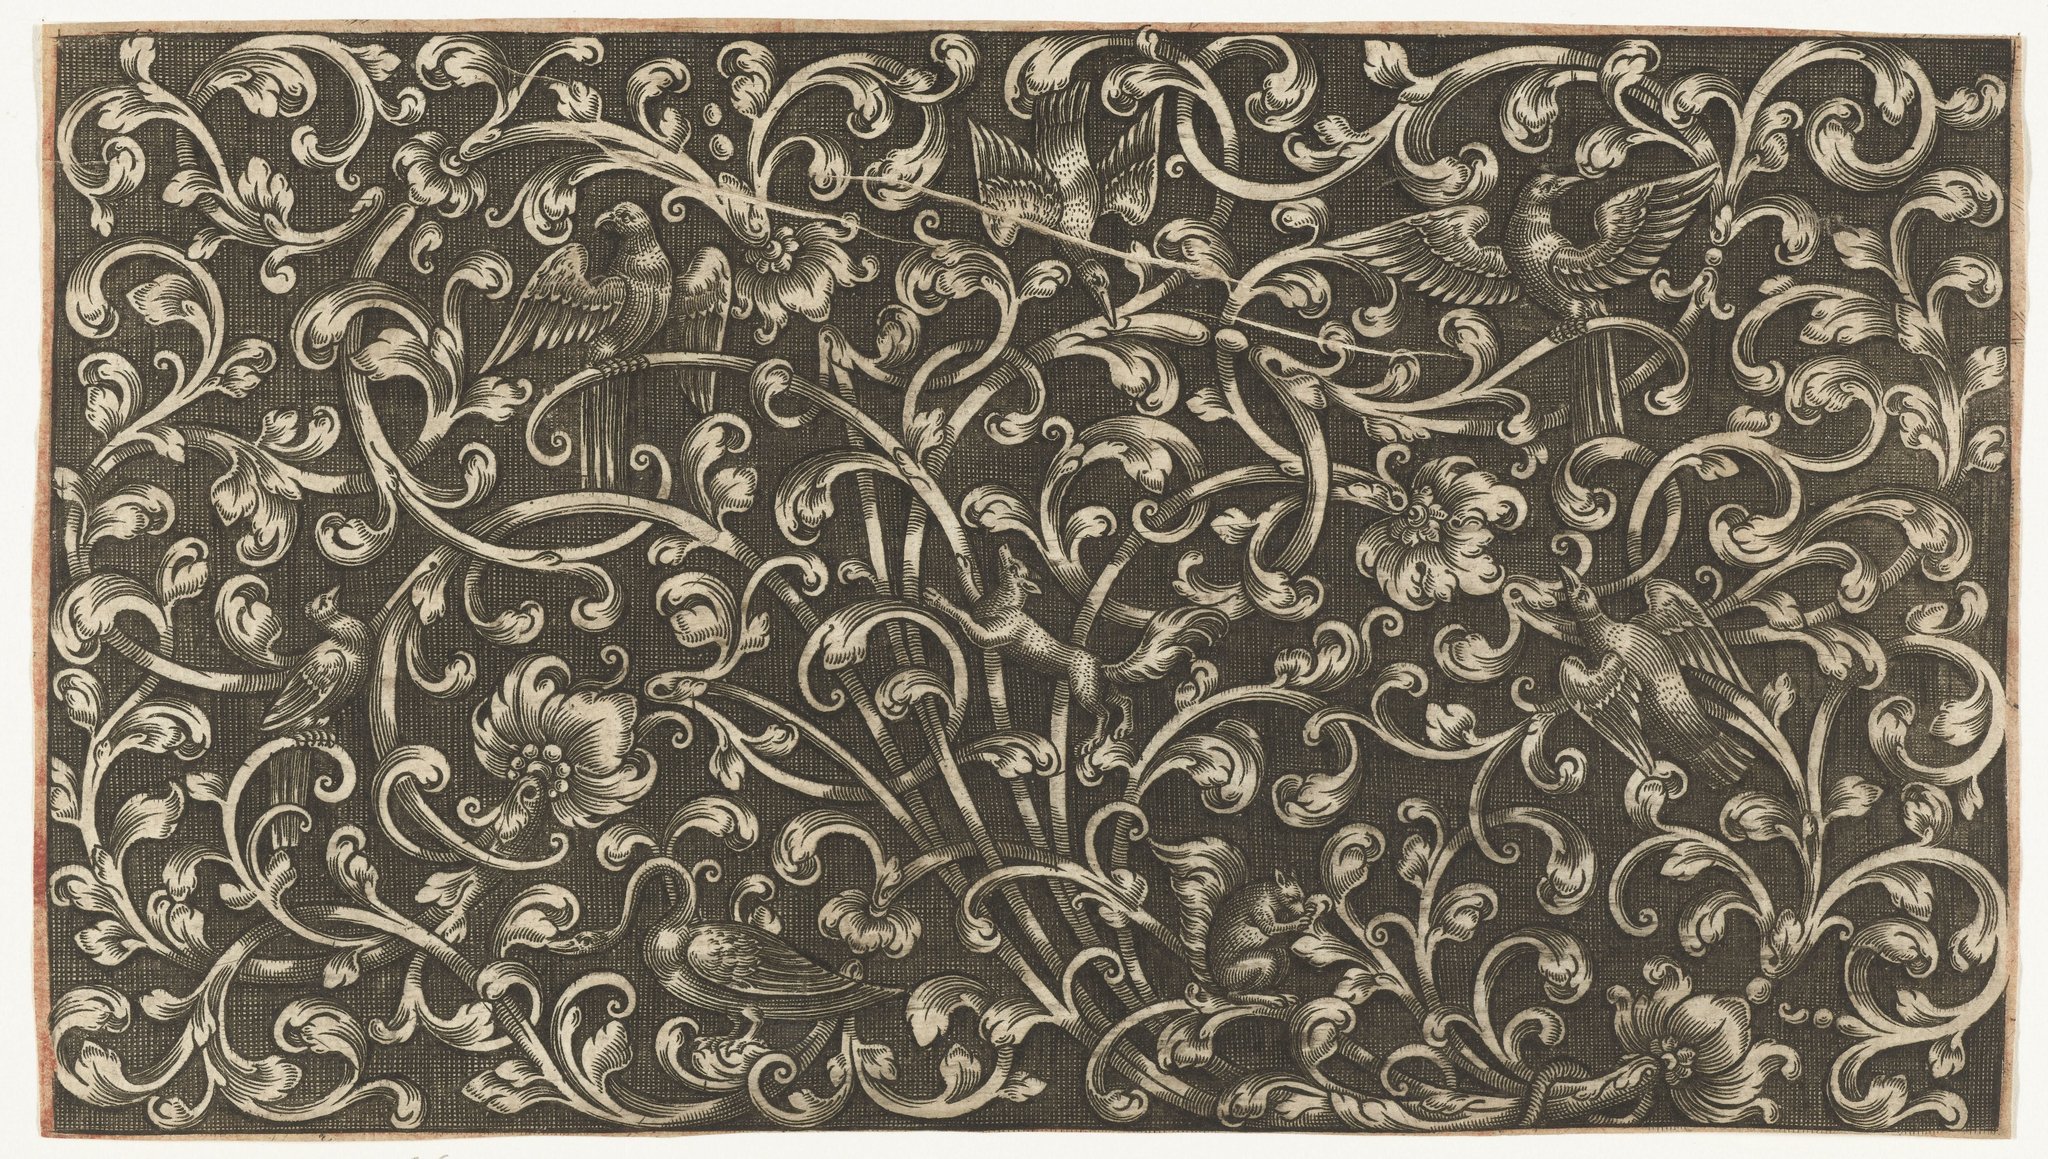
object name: ornament print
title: Rank- en bladmotieven met dieren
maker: hans janssen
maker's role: print maker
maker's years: 1605-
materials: paper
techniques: engraving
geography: netherlands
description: Rank-en bladmotieven, vogels, een vos en een eekhoorn. (vergelijk prenten Hans Janssen)